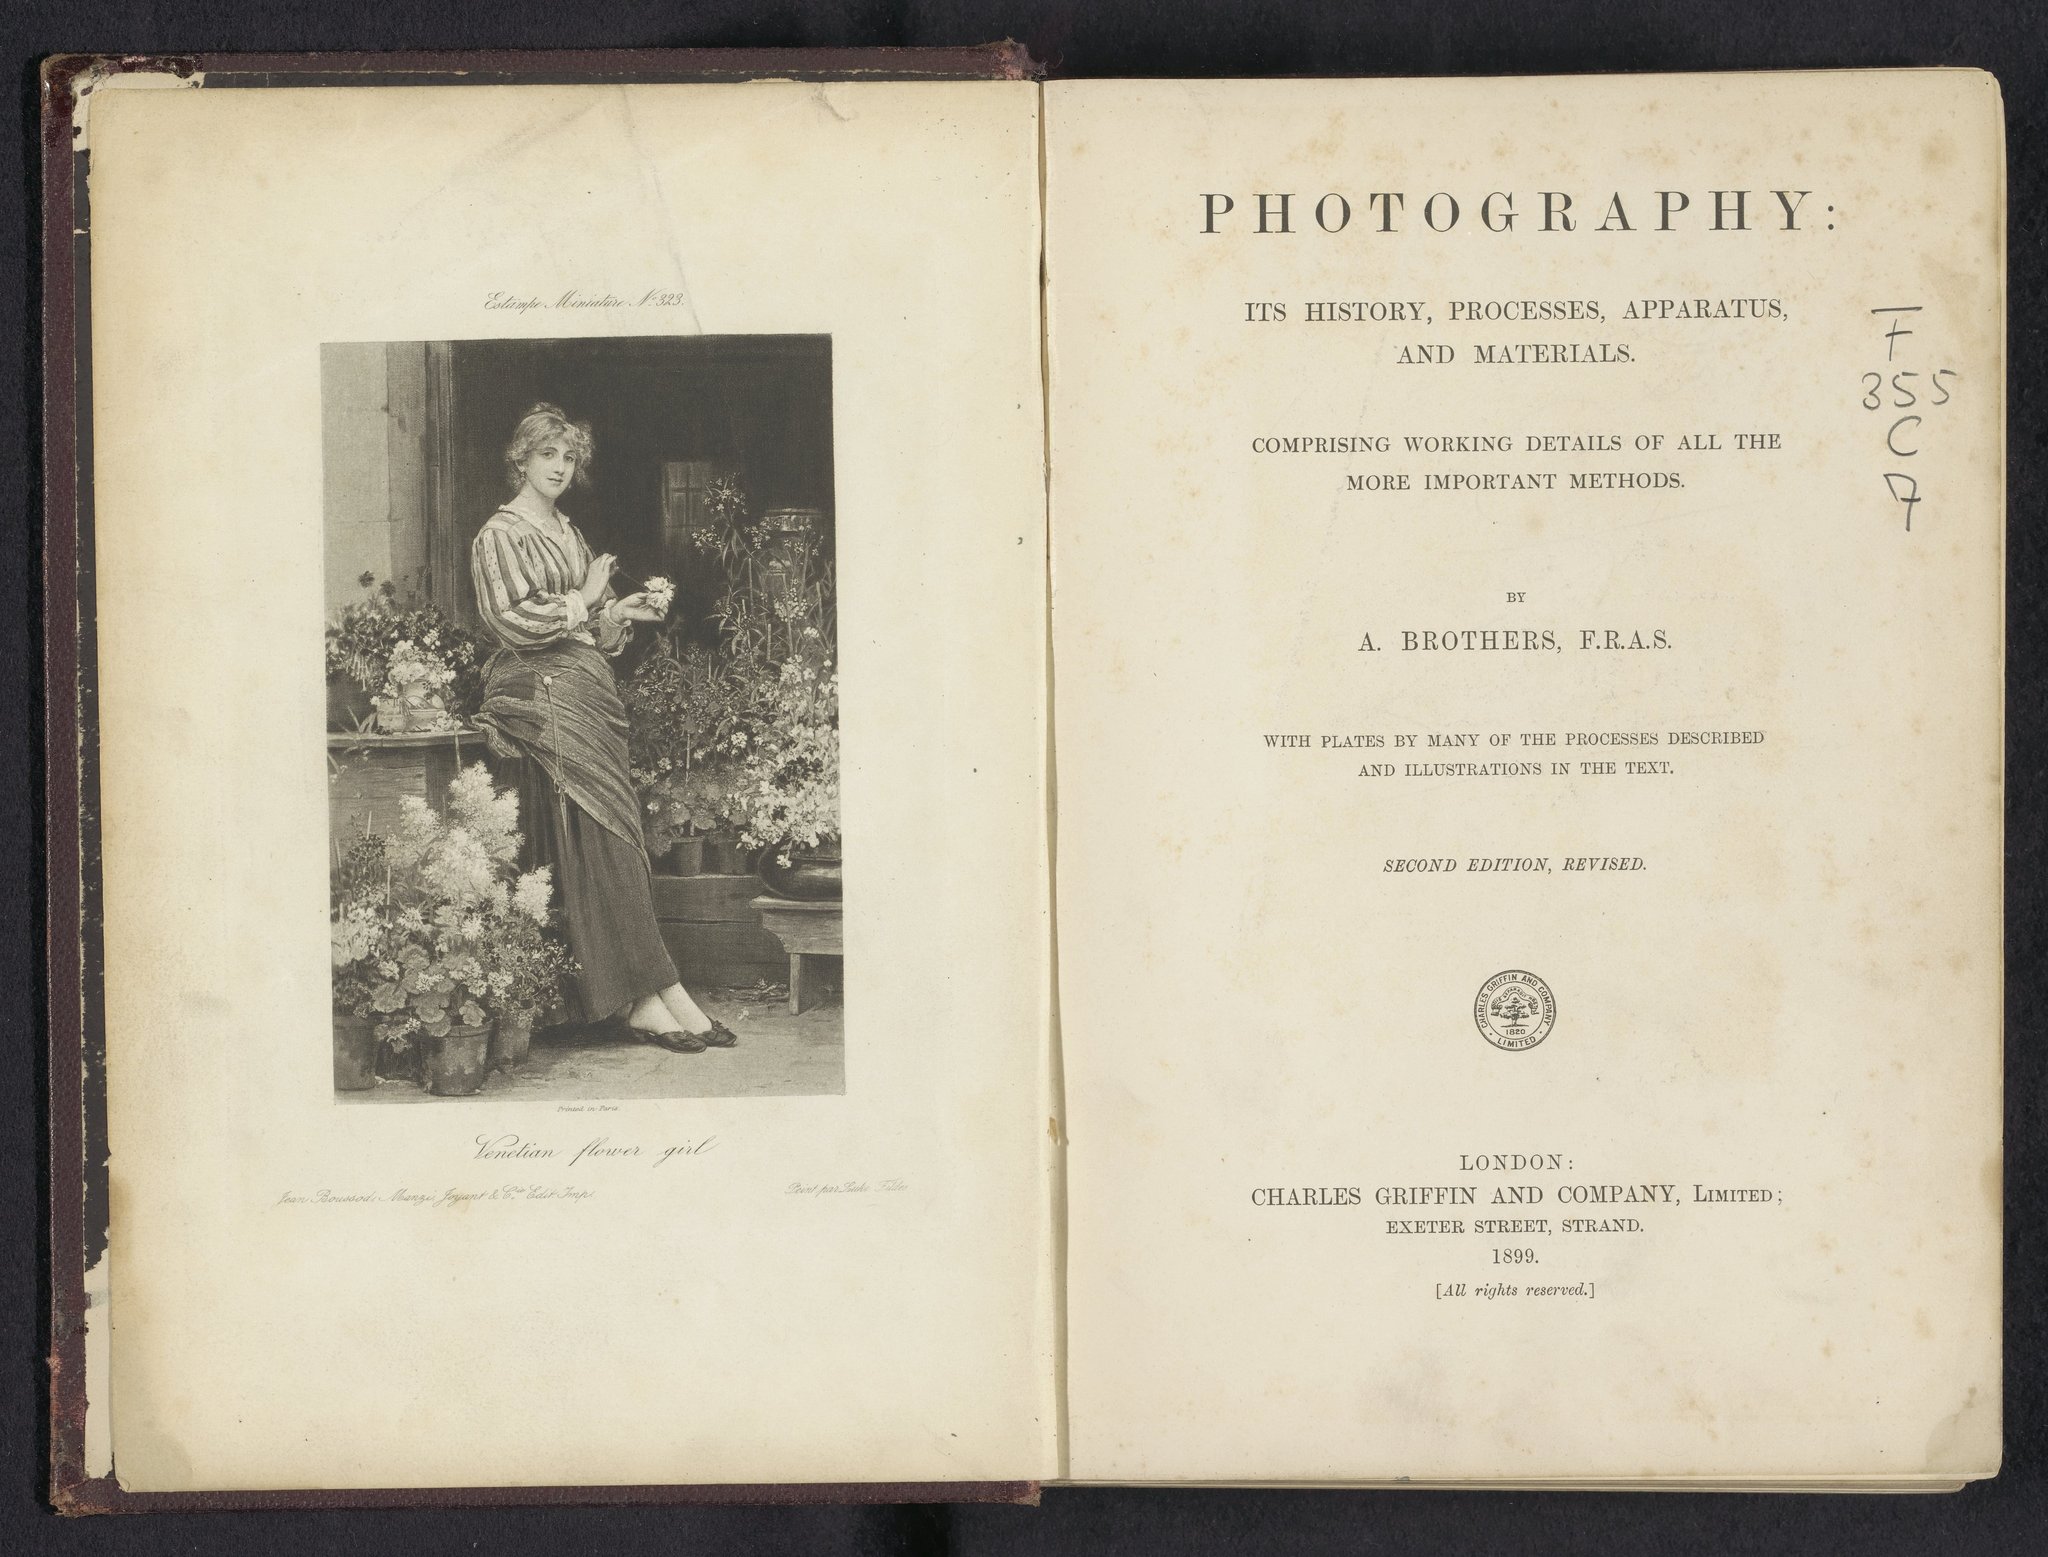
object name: book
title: Photography: its history, processes, apparatus, and materials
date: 1899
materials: cardboard, linen, paper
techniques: photograph, offset printed, photoaquatint, photogalvanography, photolithography, printing, woodburygravure, woodburytype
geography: london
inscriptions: inscription: ‘ex libris SFJ’, inscription: ‘George W Carroll 14 Vernon Street Bury Lane’